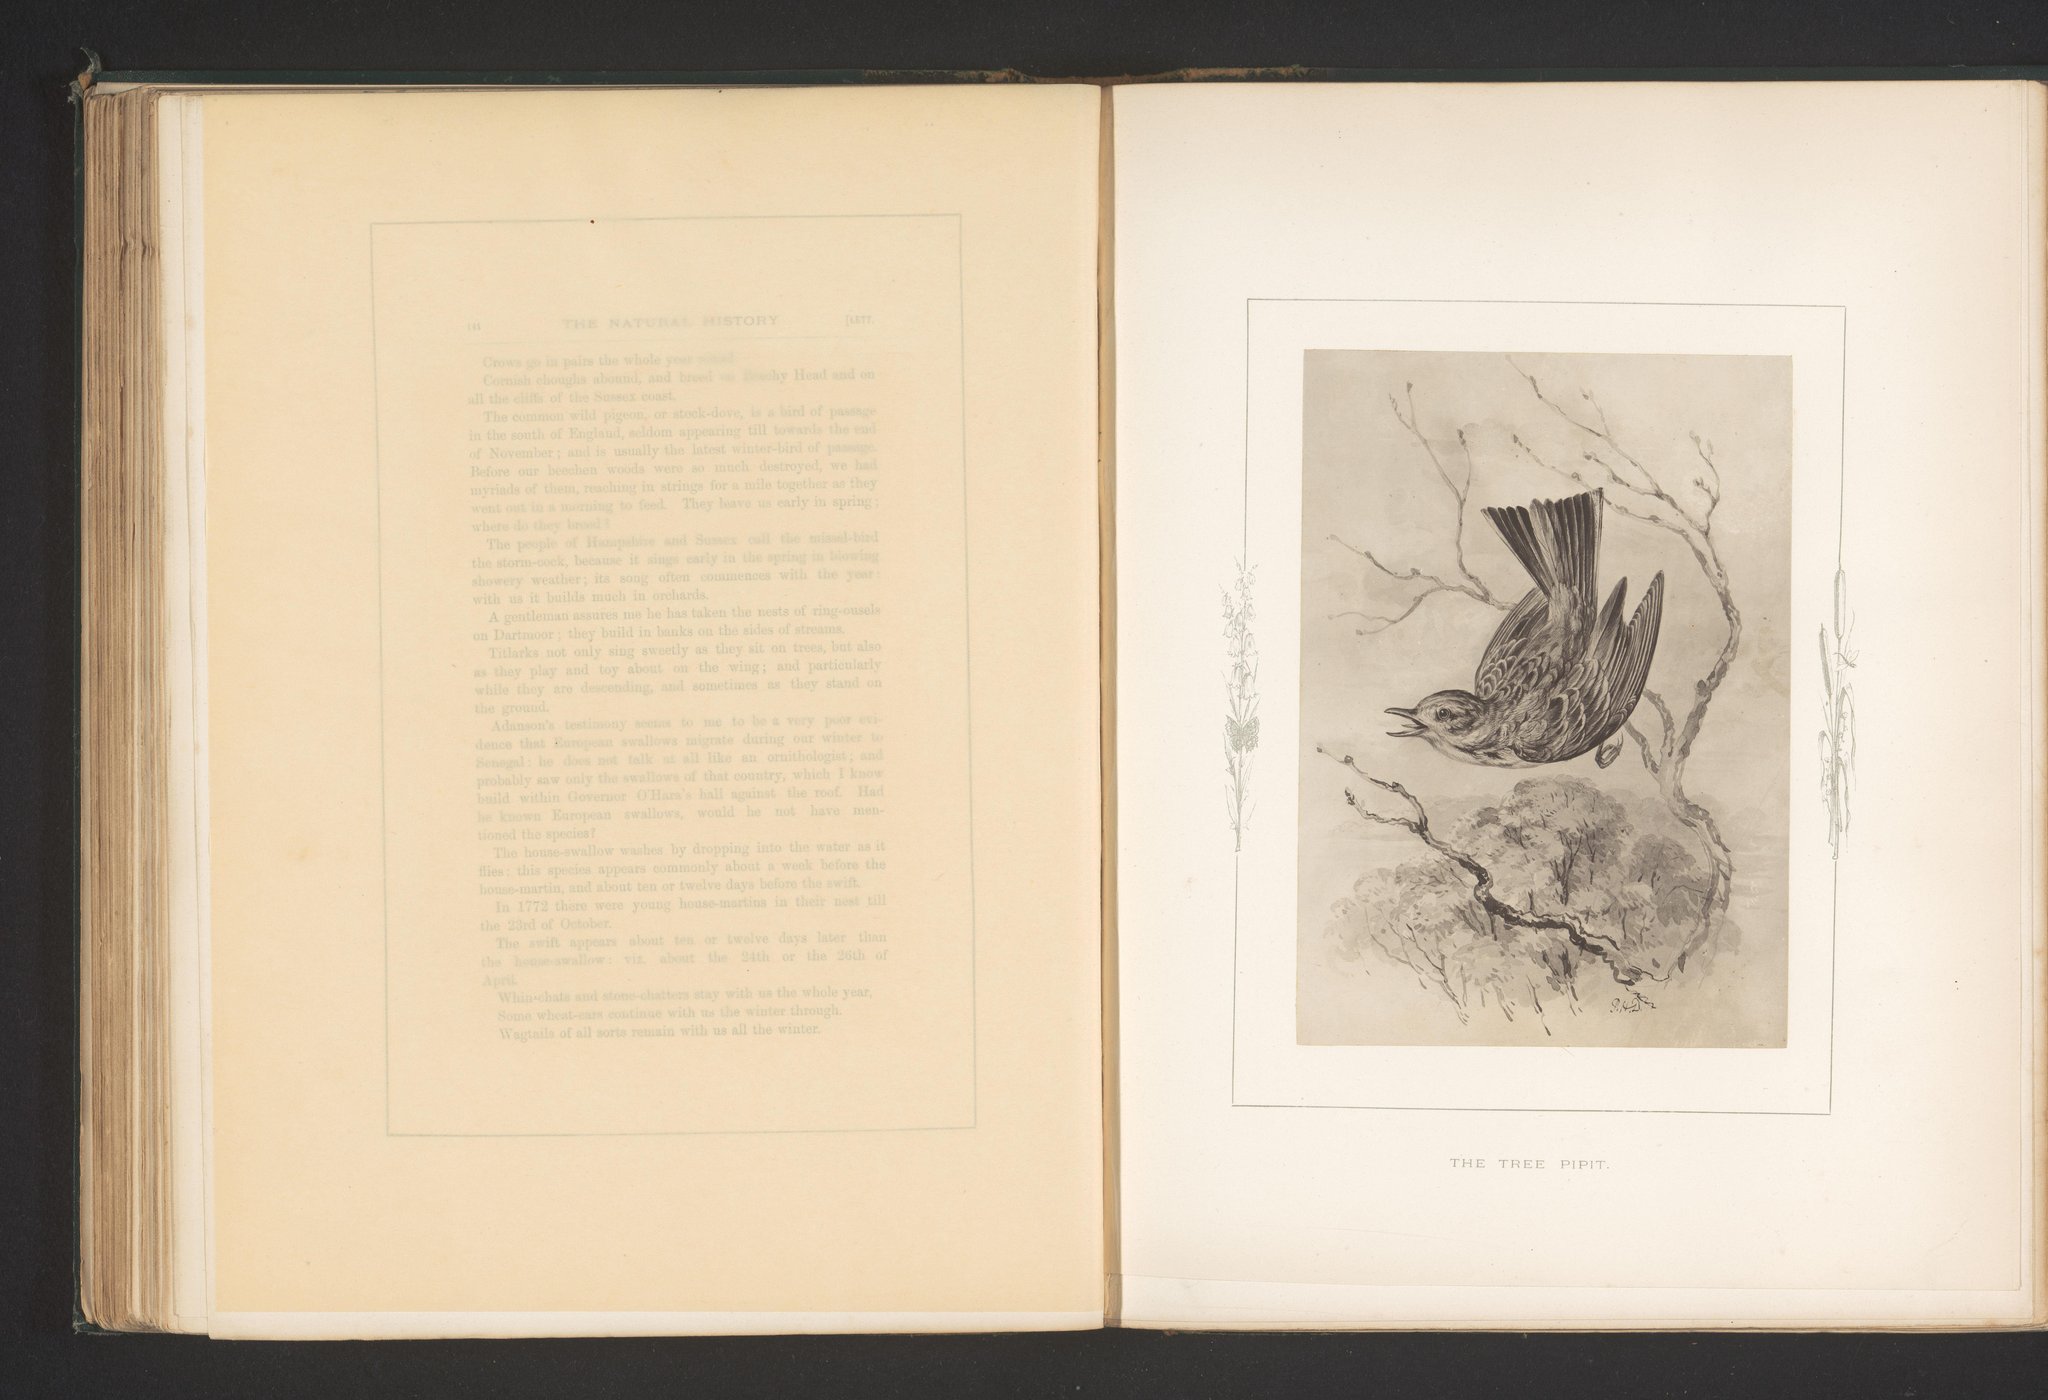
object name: photograph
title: The tree pipit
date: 1850-1876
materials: photographic support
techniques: carbon print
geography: selborne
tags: birds